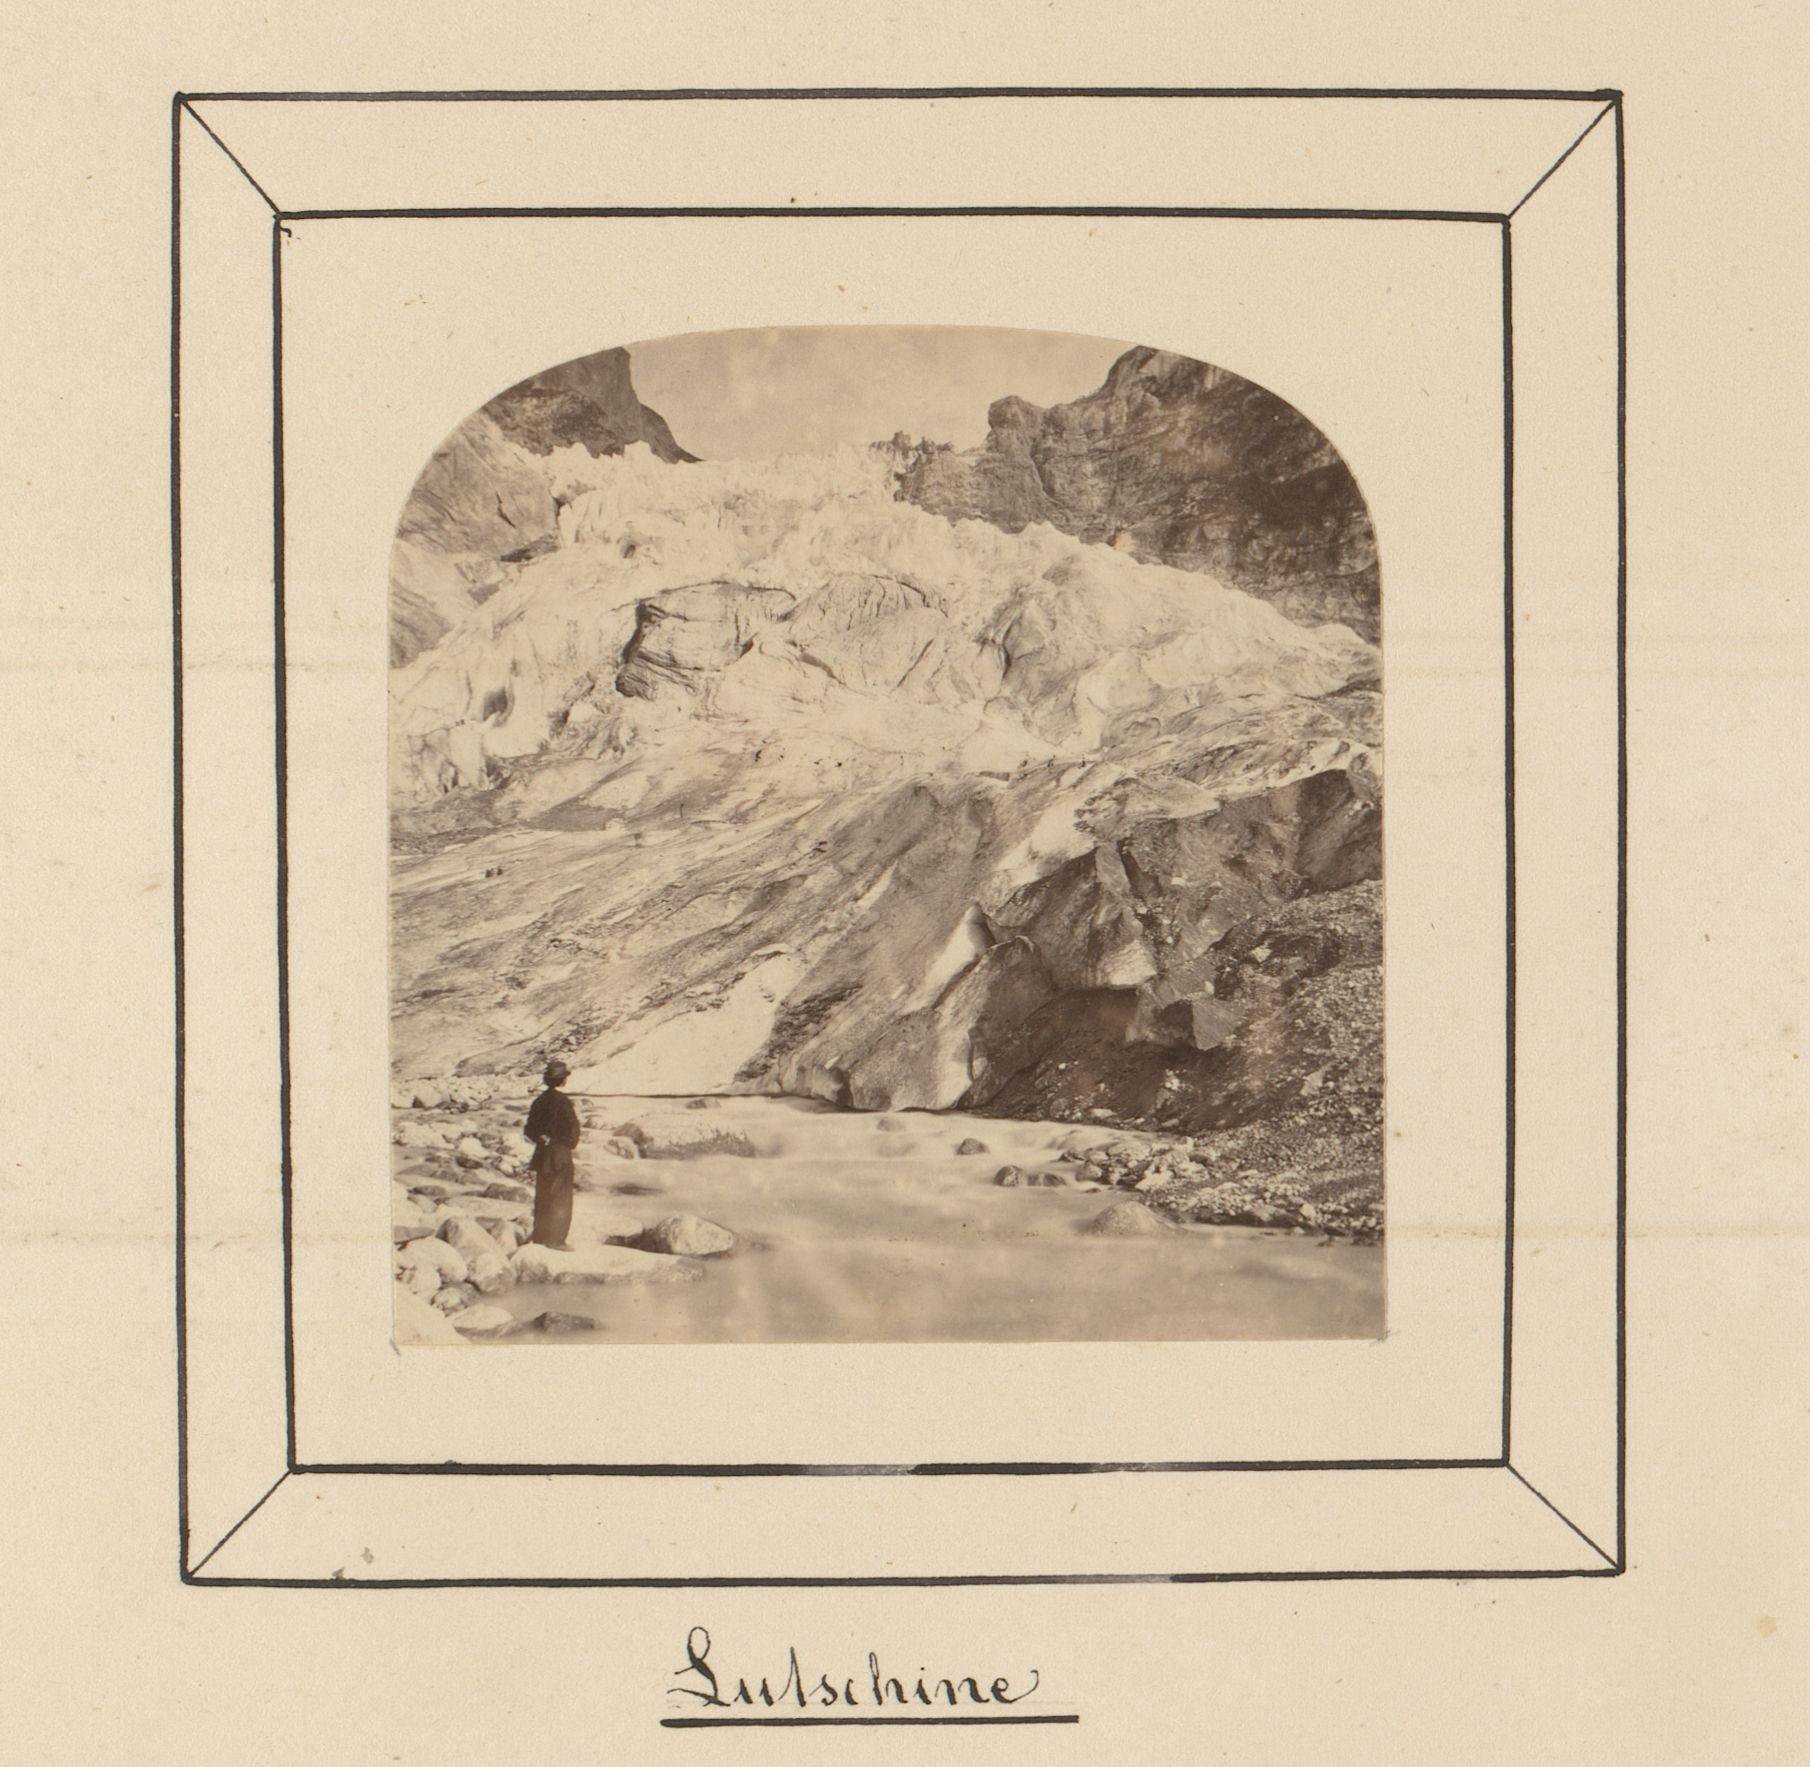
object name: album leaf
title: Man bij de Tschingelfirn aan het begin van de Lütschine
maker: Anonymous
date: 1870-1890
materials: paper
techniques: albumen print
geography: tschingelfirn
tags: glacier, spring, source of river or stream